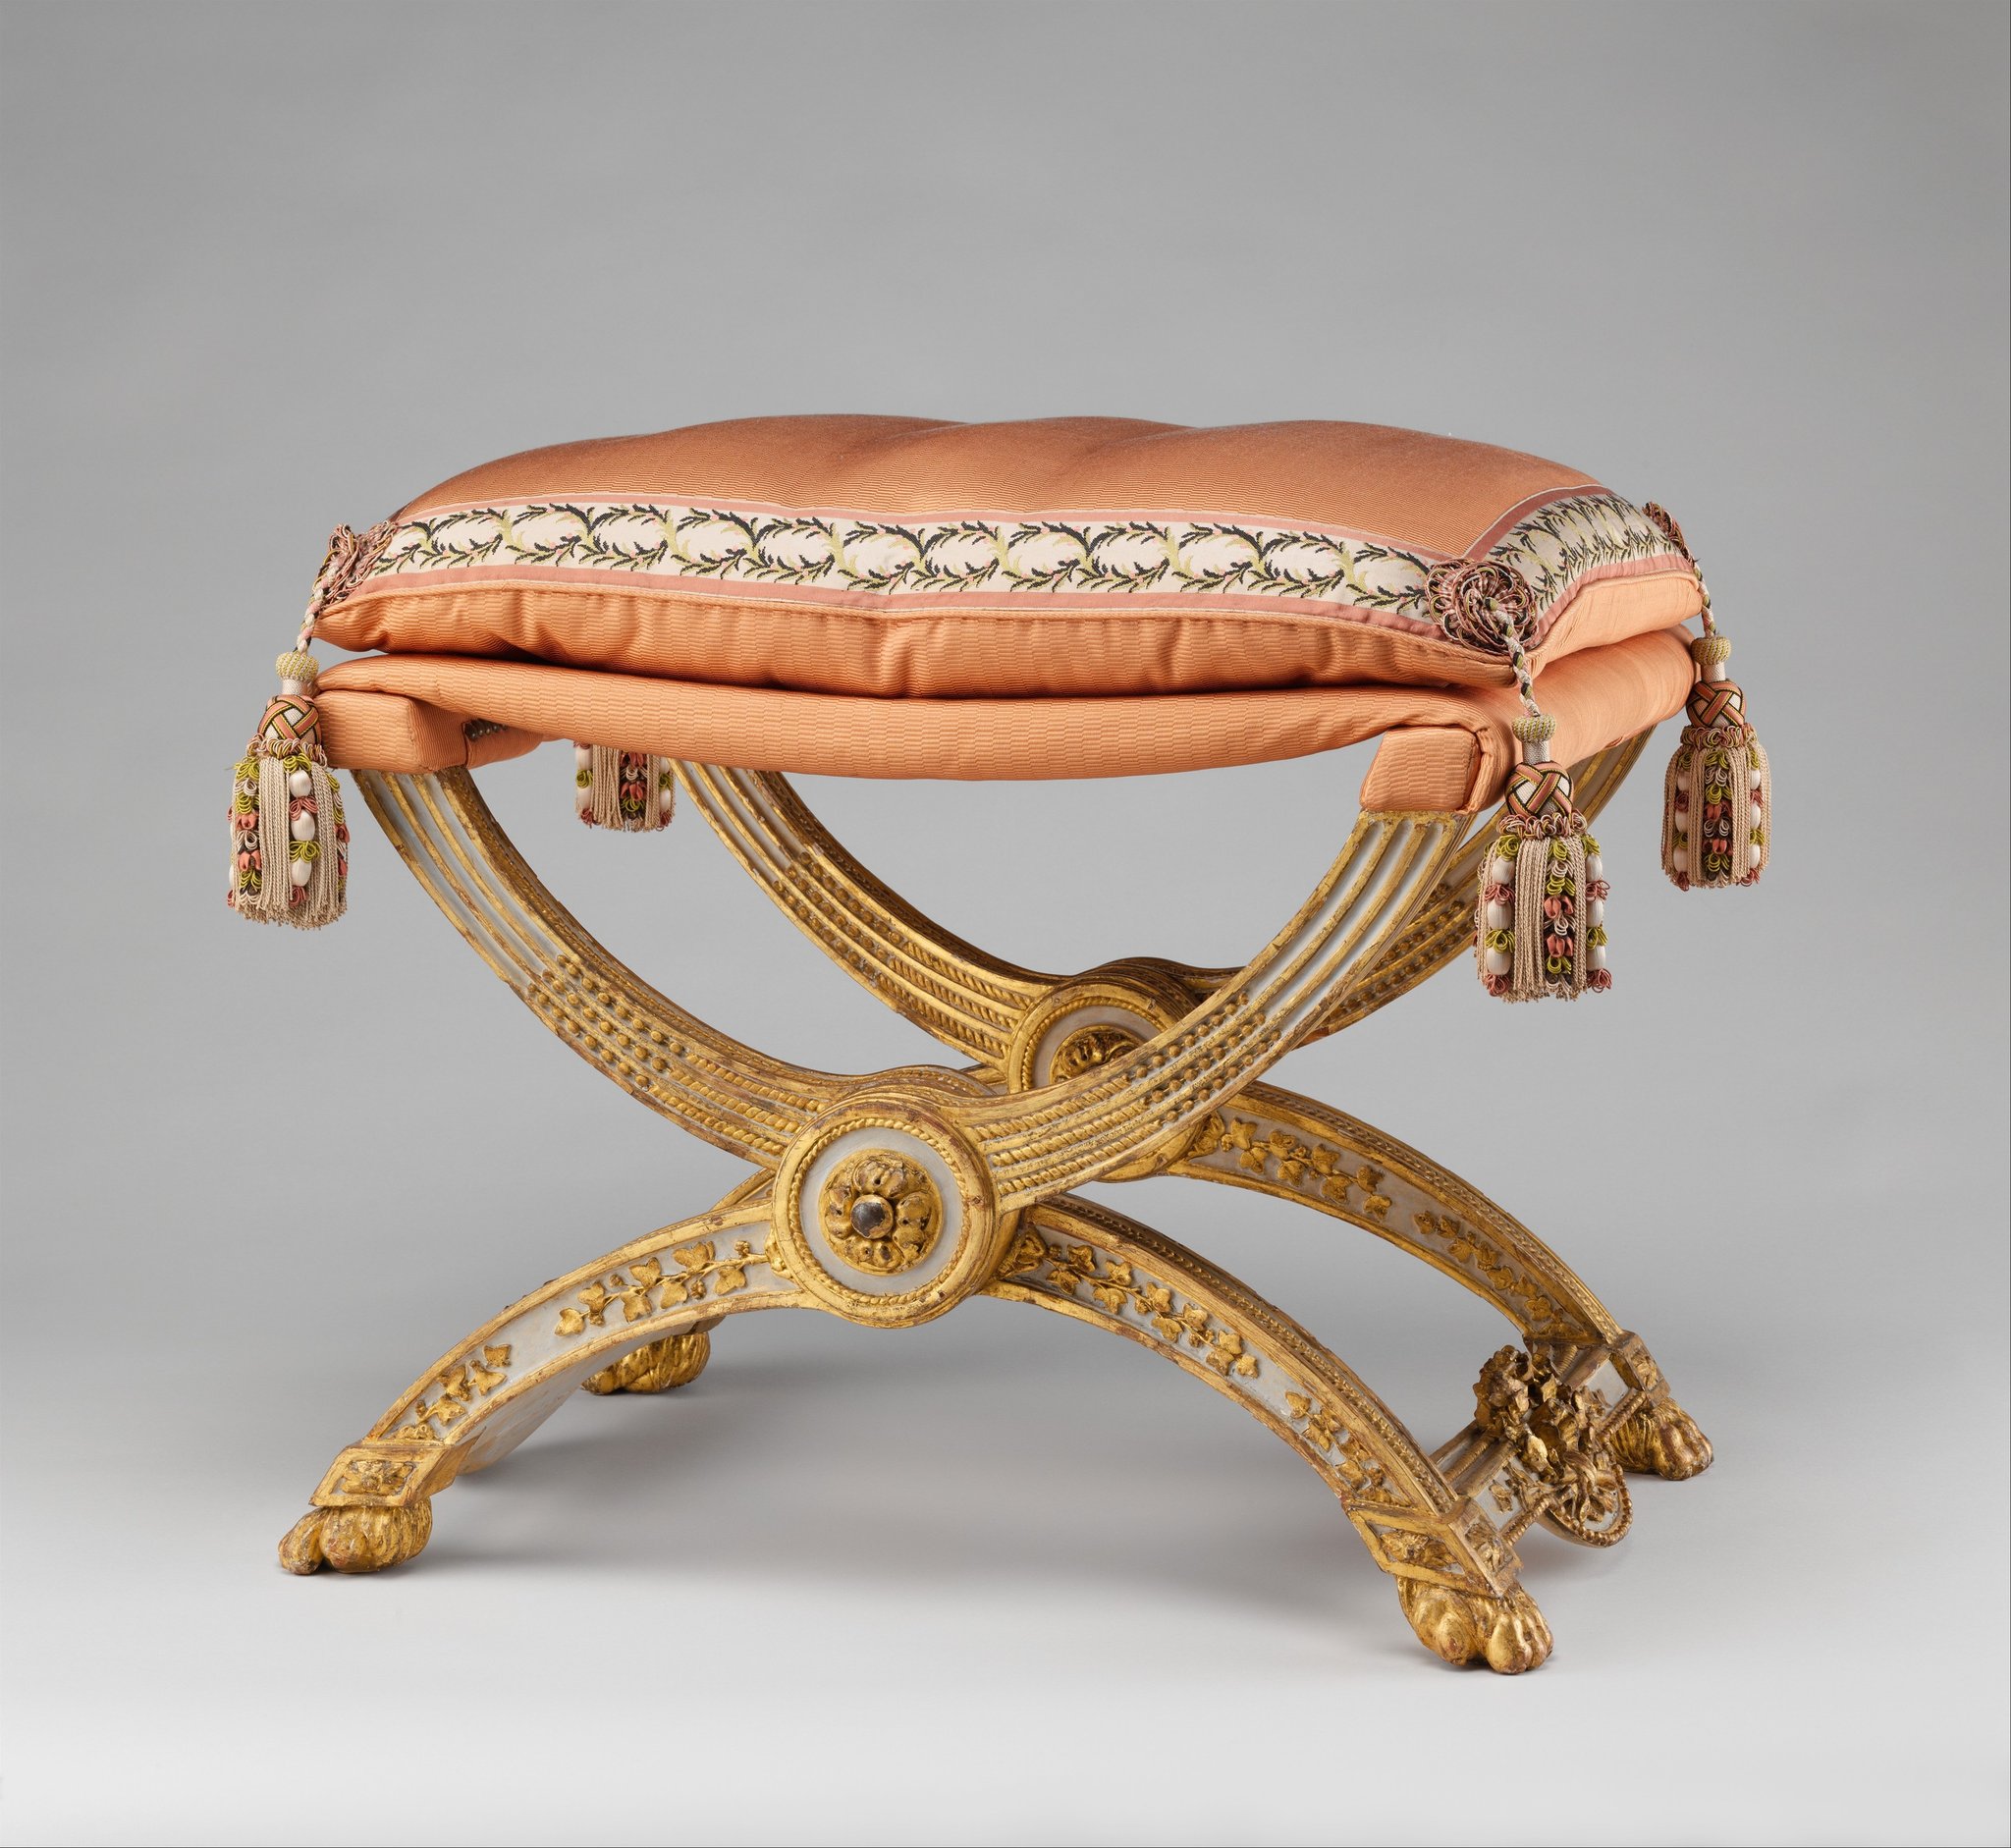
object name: folding stool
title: Folding stool (pliant) (one of a pair)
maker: jean-baptiste-claude sené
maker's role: maker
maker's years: 1748-1803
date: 1786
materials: wood, silk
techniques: carving, painting